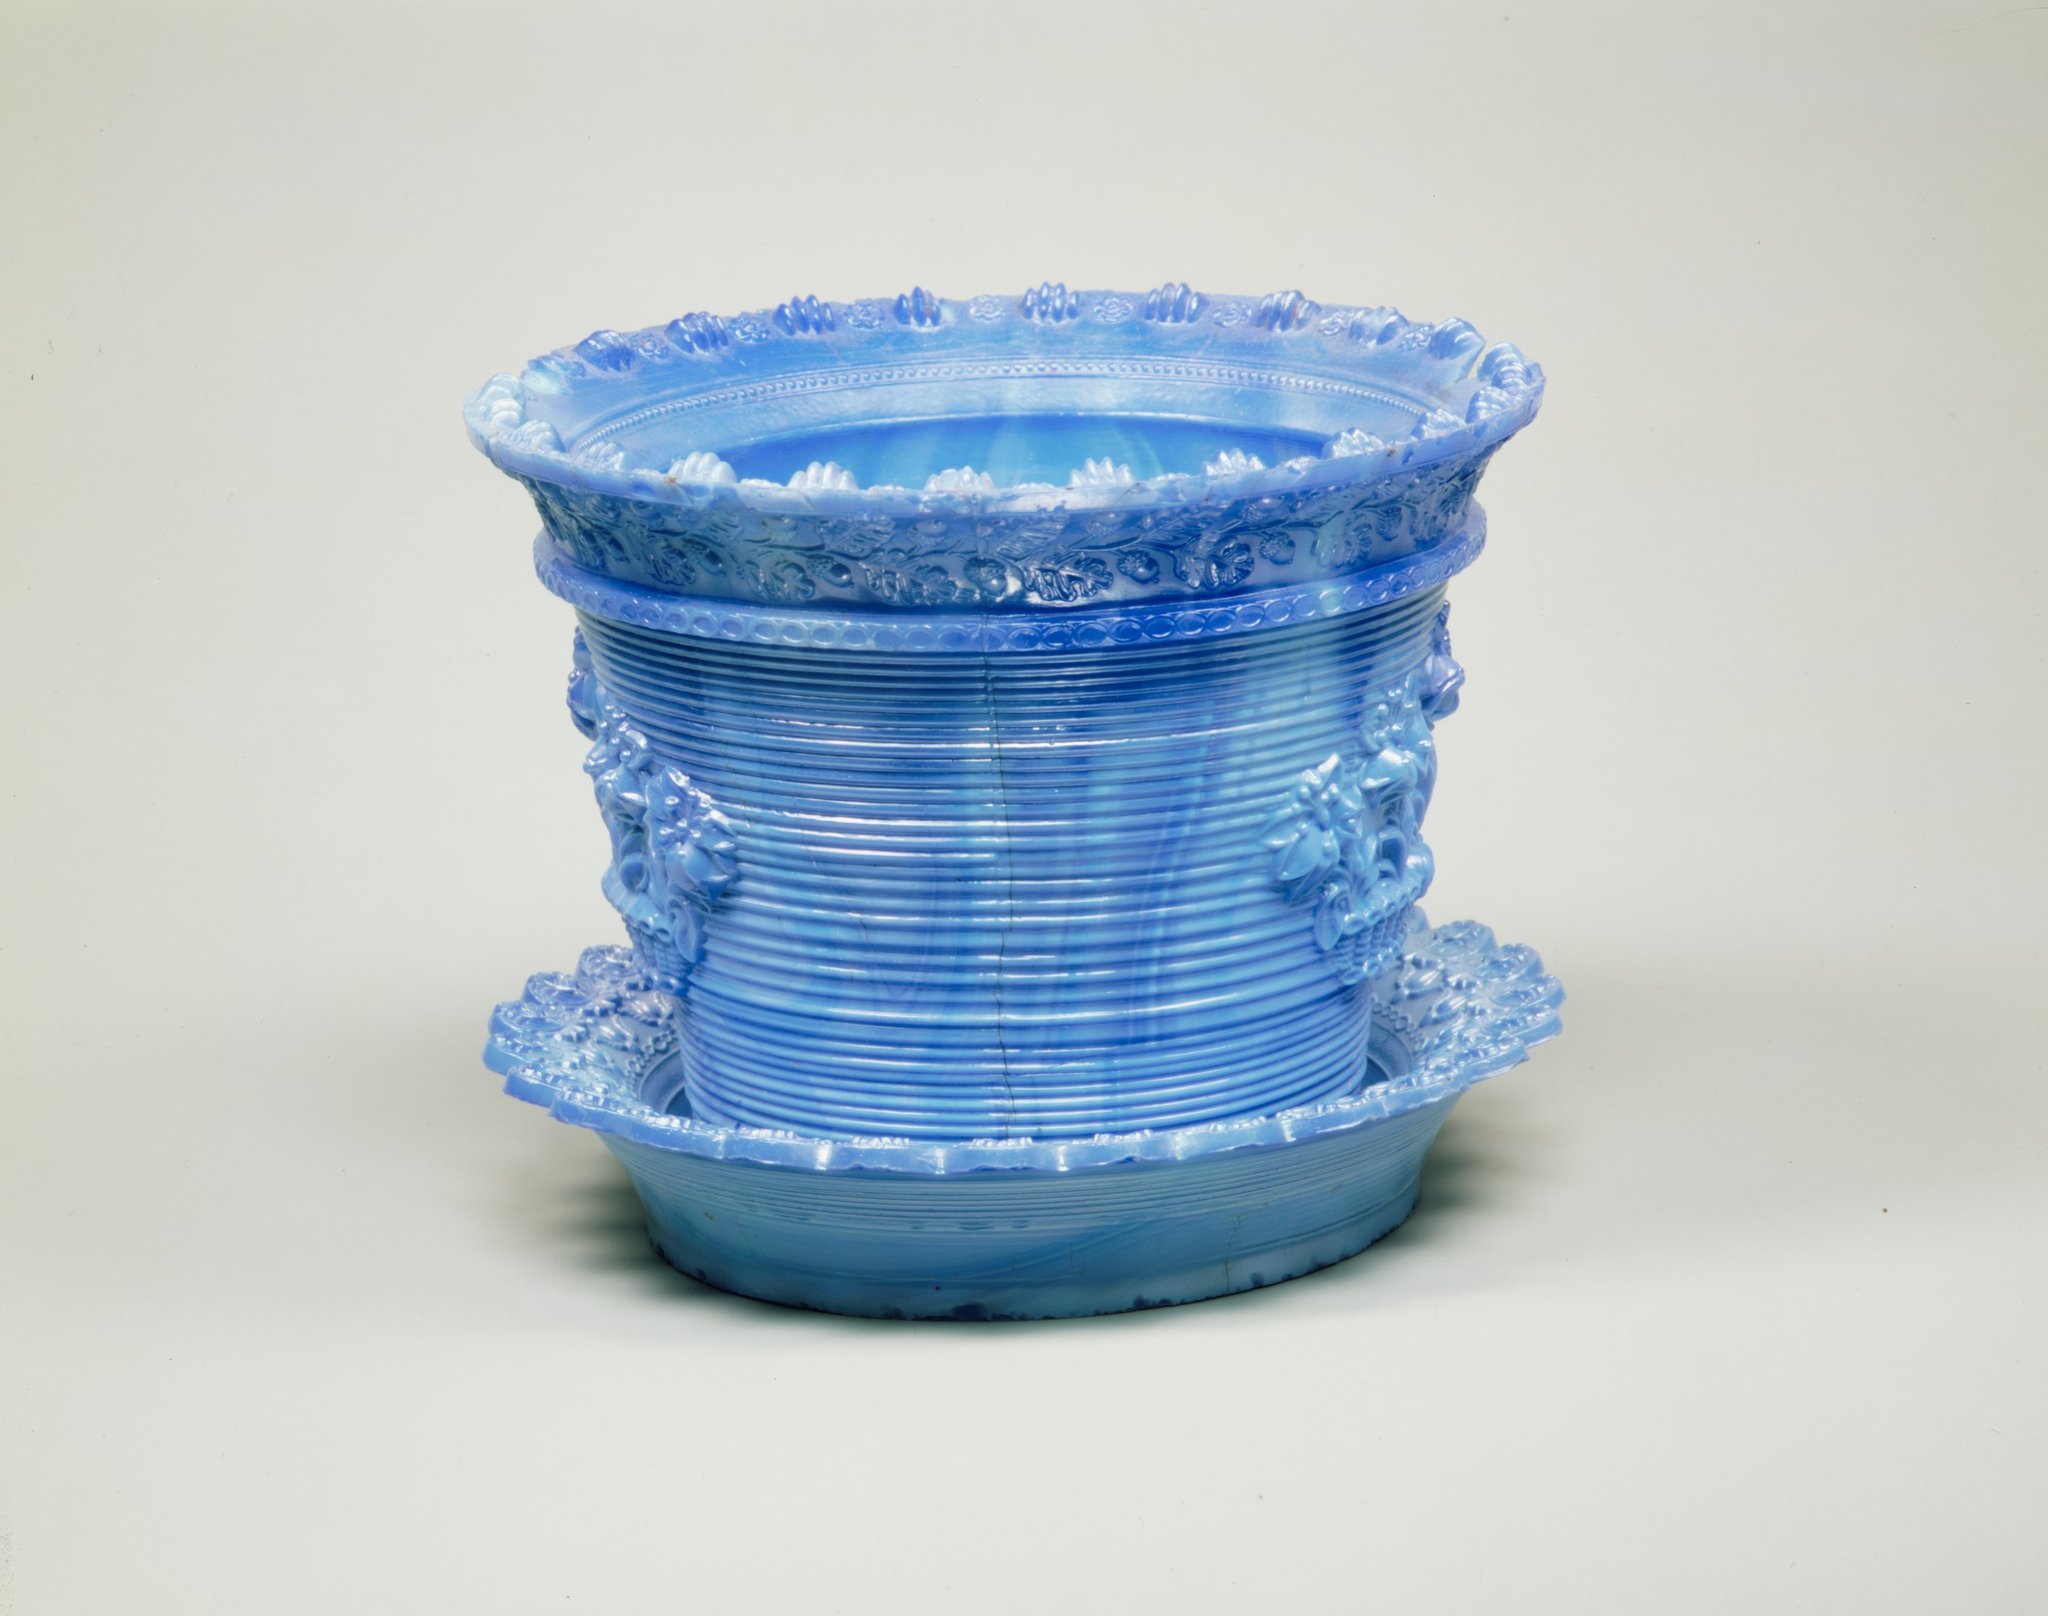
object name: flowerpot and stand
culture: american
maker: boston & sandwich glass company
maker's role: manufacturer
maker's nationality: american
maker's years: 1825-1888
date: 1830-1835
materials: glass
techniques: pressed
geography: united states